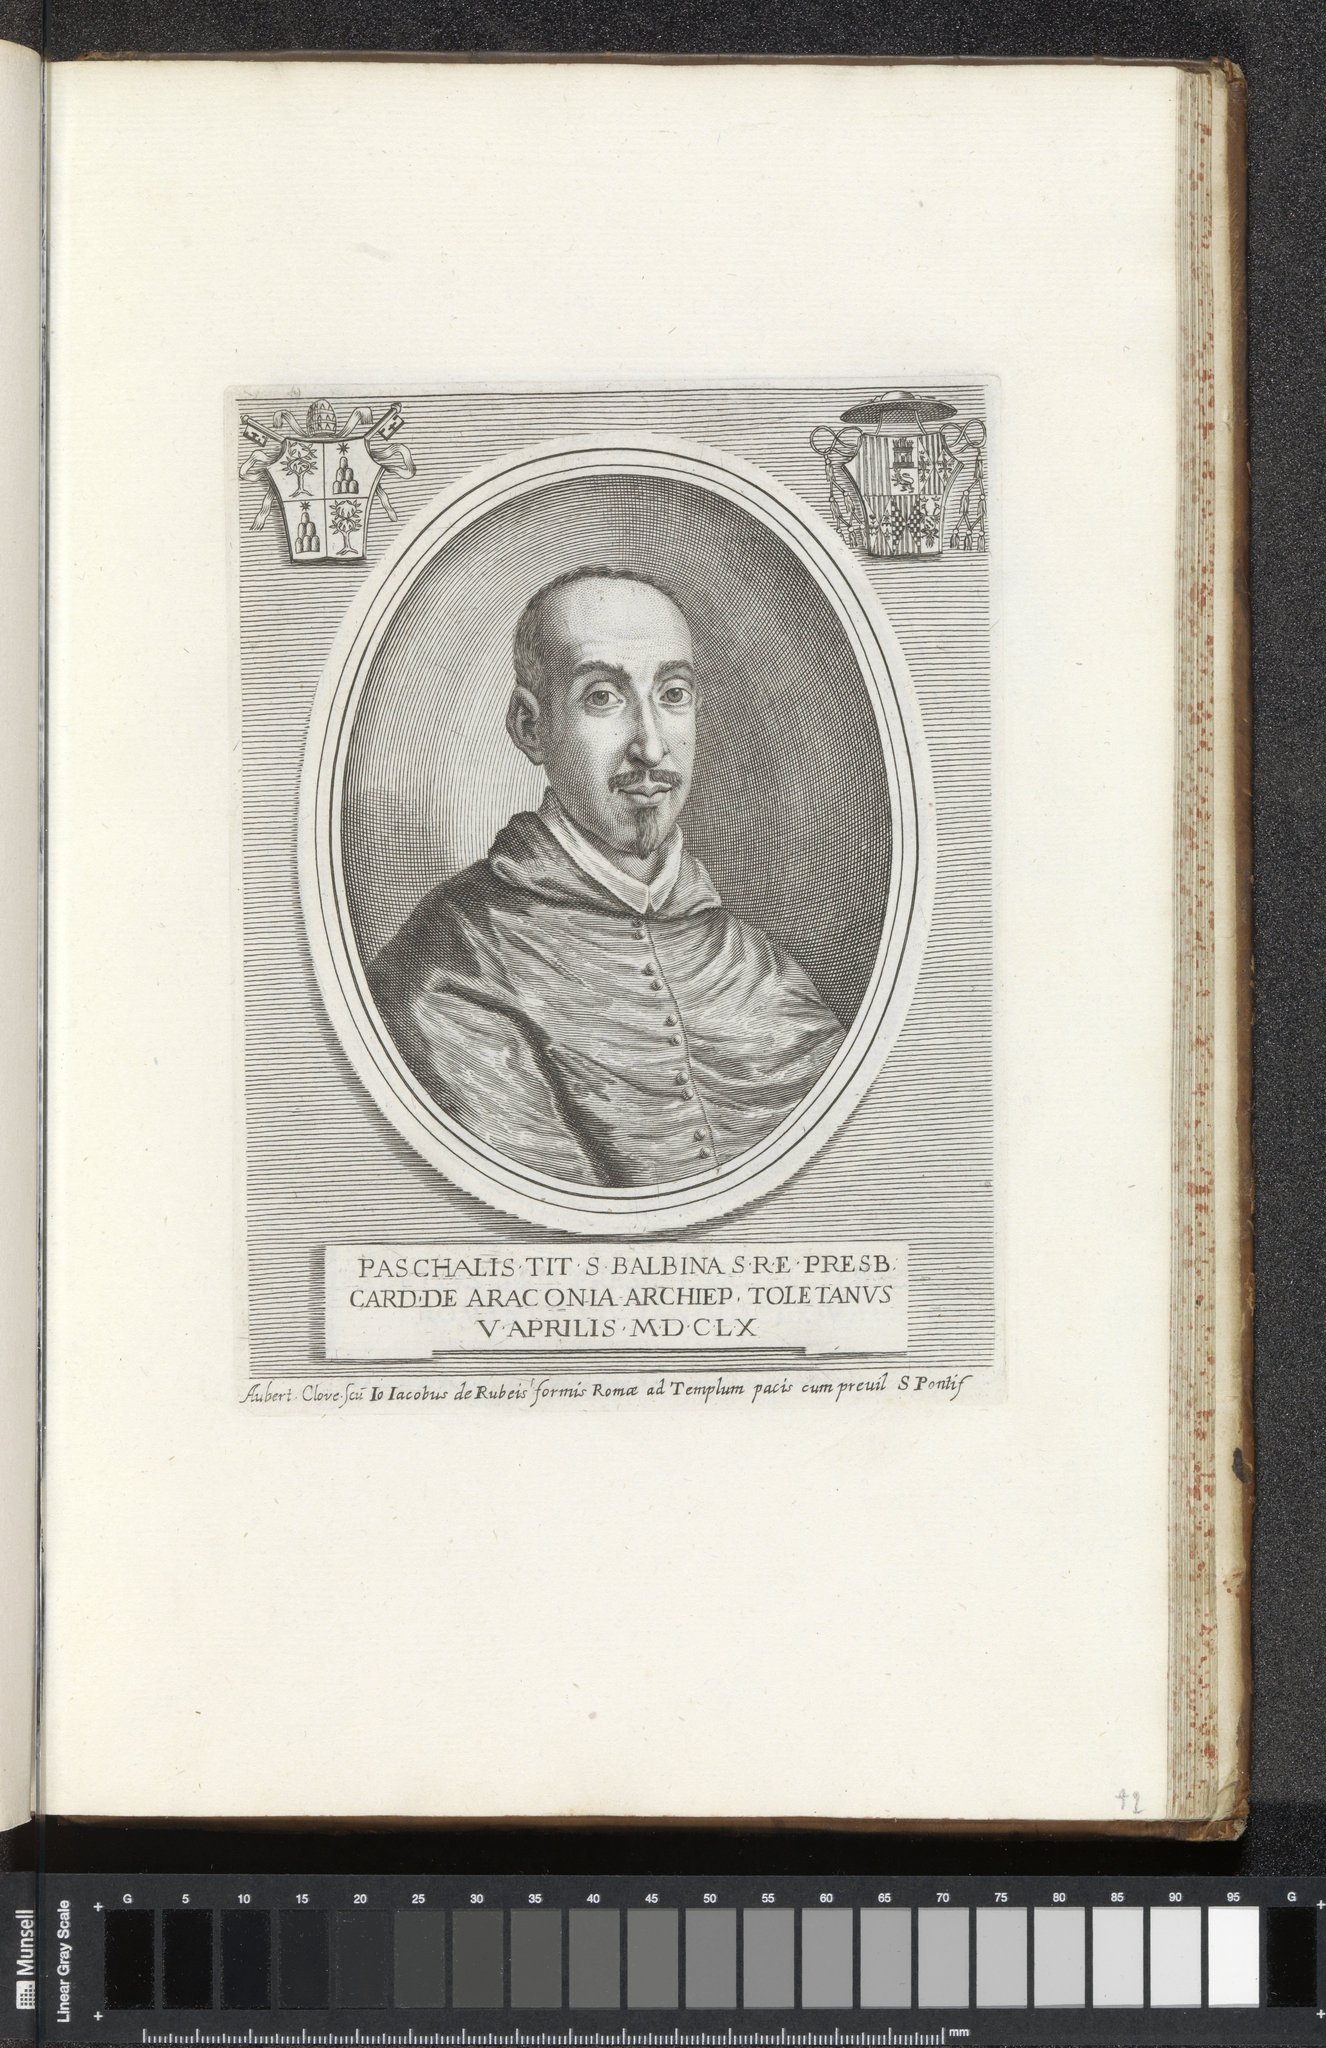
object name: print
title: Effigies Nomina et Cognomina S.D.N. Alexandri Papae VII et RR. DD. SRE. Cardd (...).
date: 1660-1679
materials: paper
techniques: engraving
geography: rome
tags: cardinal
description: Portret van kardinaal Pascual de Aragón. Linksboven het wapen van paus Alexander VII en rechtsboven het wapen van de kardinaal. Onderaan een onderschrift in het Latijn. De prent maakt deel uit van een album.